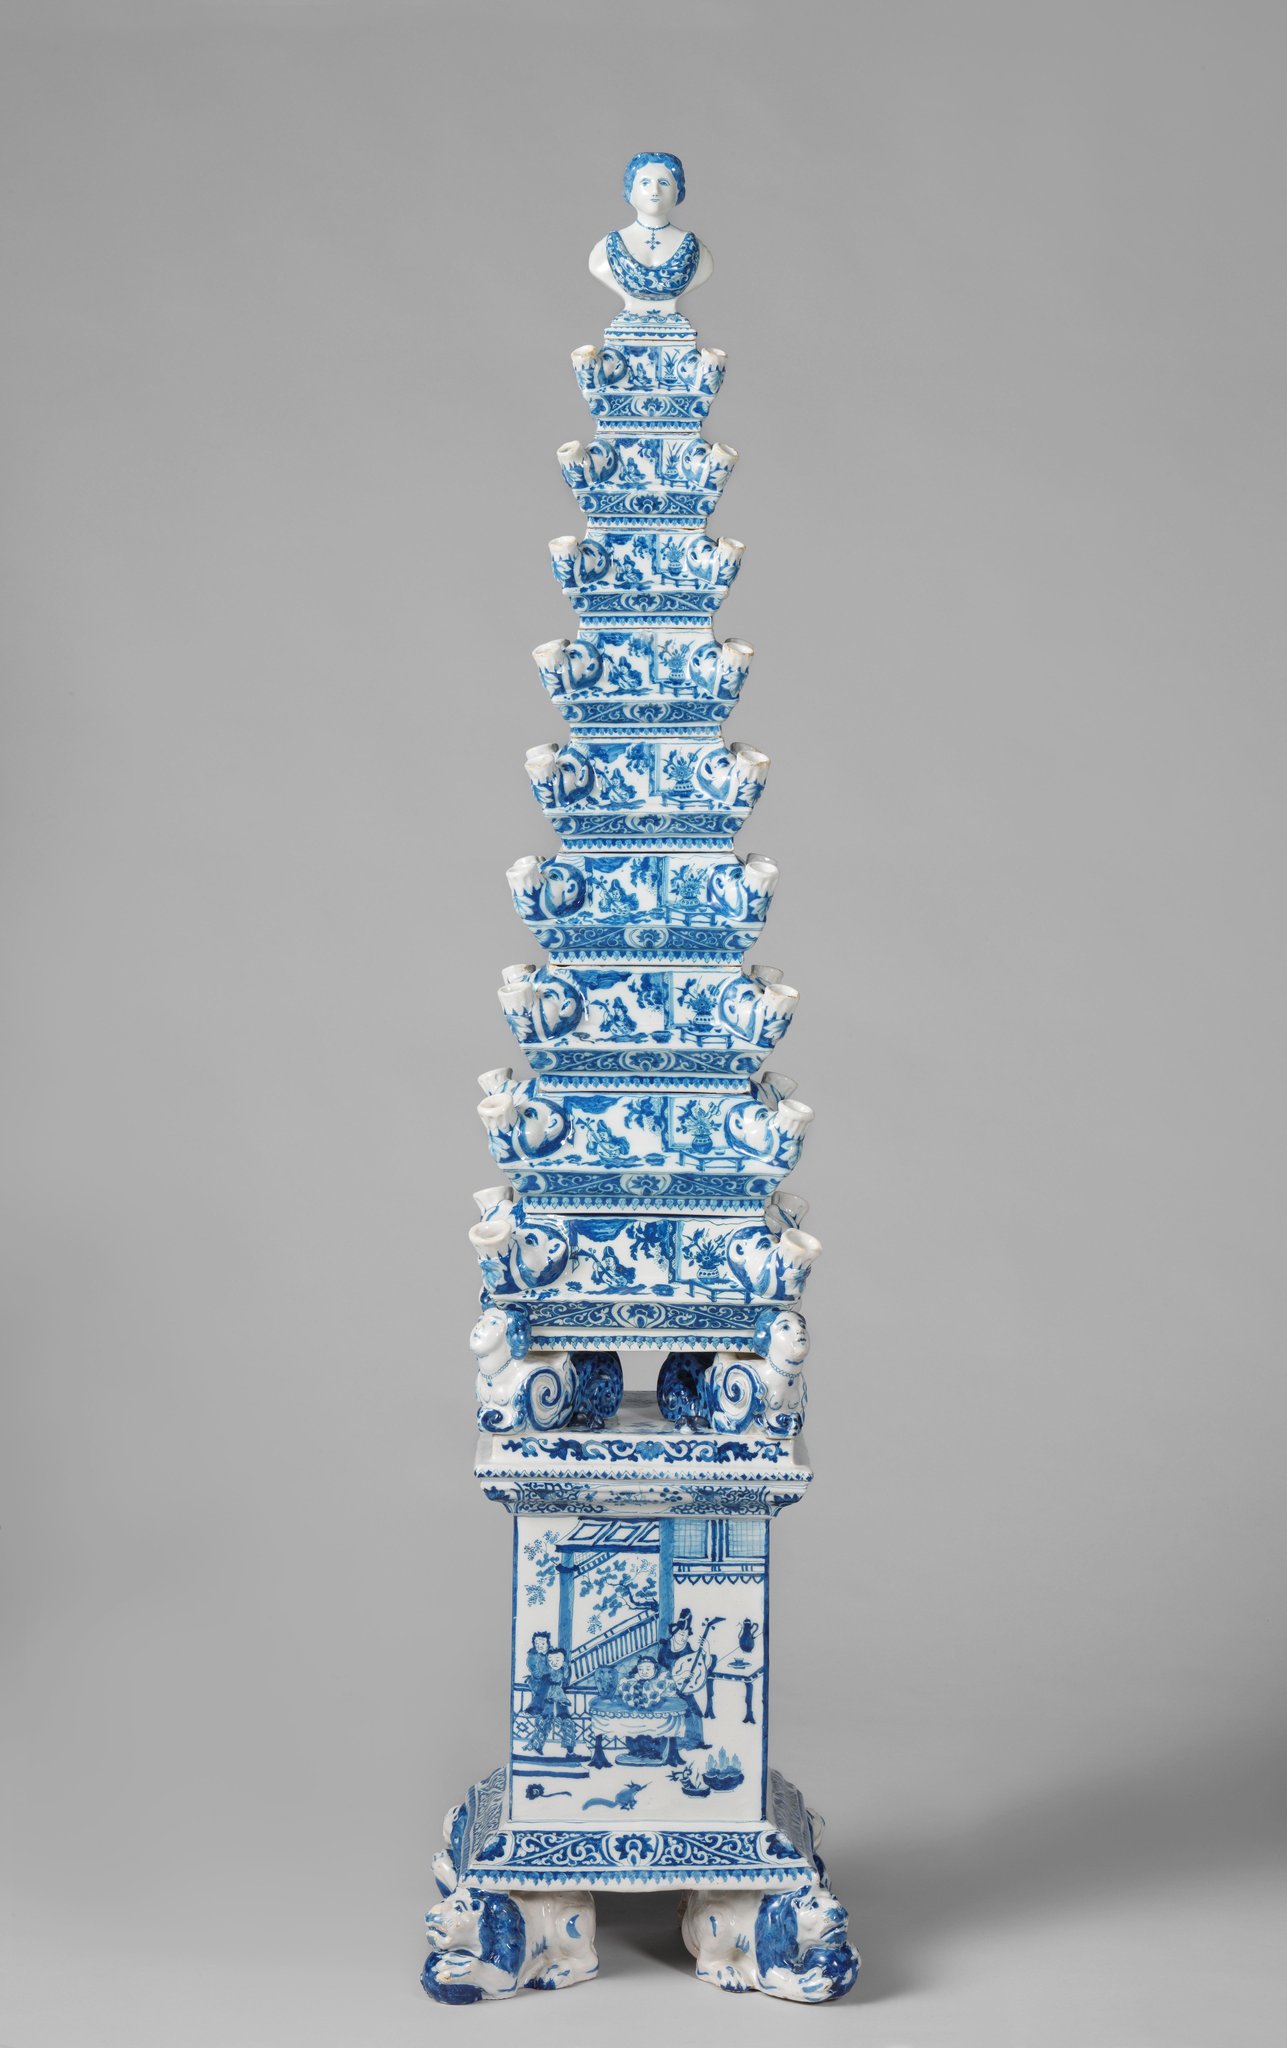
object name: bloempiramide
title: Flower pyramid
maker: lambertus van eenhoorn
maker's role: plateelbakker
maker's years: 1651-1721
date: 1692-1700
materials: earthenware, glaze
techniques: painted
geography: delft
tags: flowers, one person playing string instrument (plucked), beasts of prey, predatory animals: lion, chest, bust - aa - female human figure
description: Segment van bloempiramide van faience, blauw beschilderd in de glazuur. Musicerende figuren en figuren met schaal.